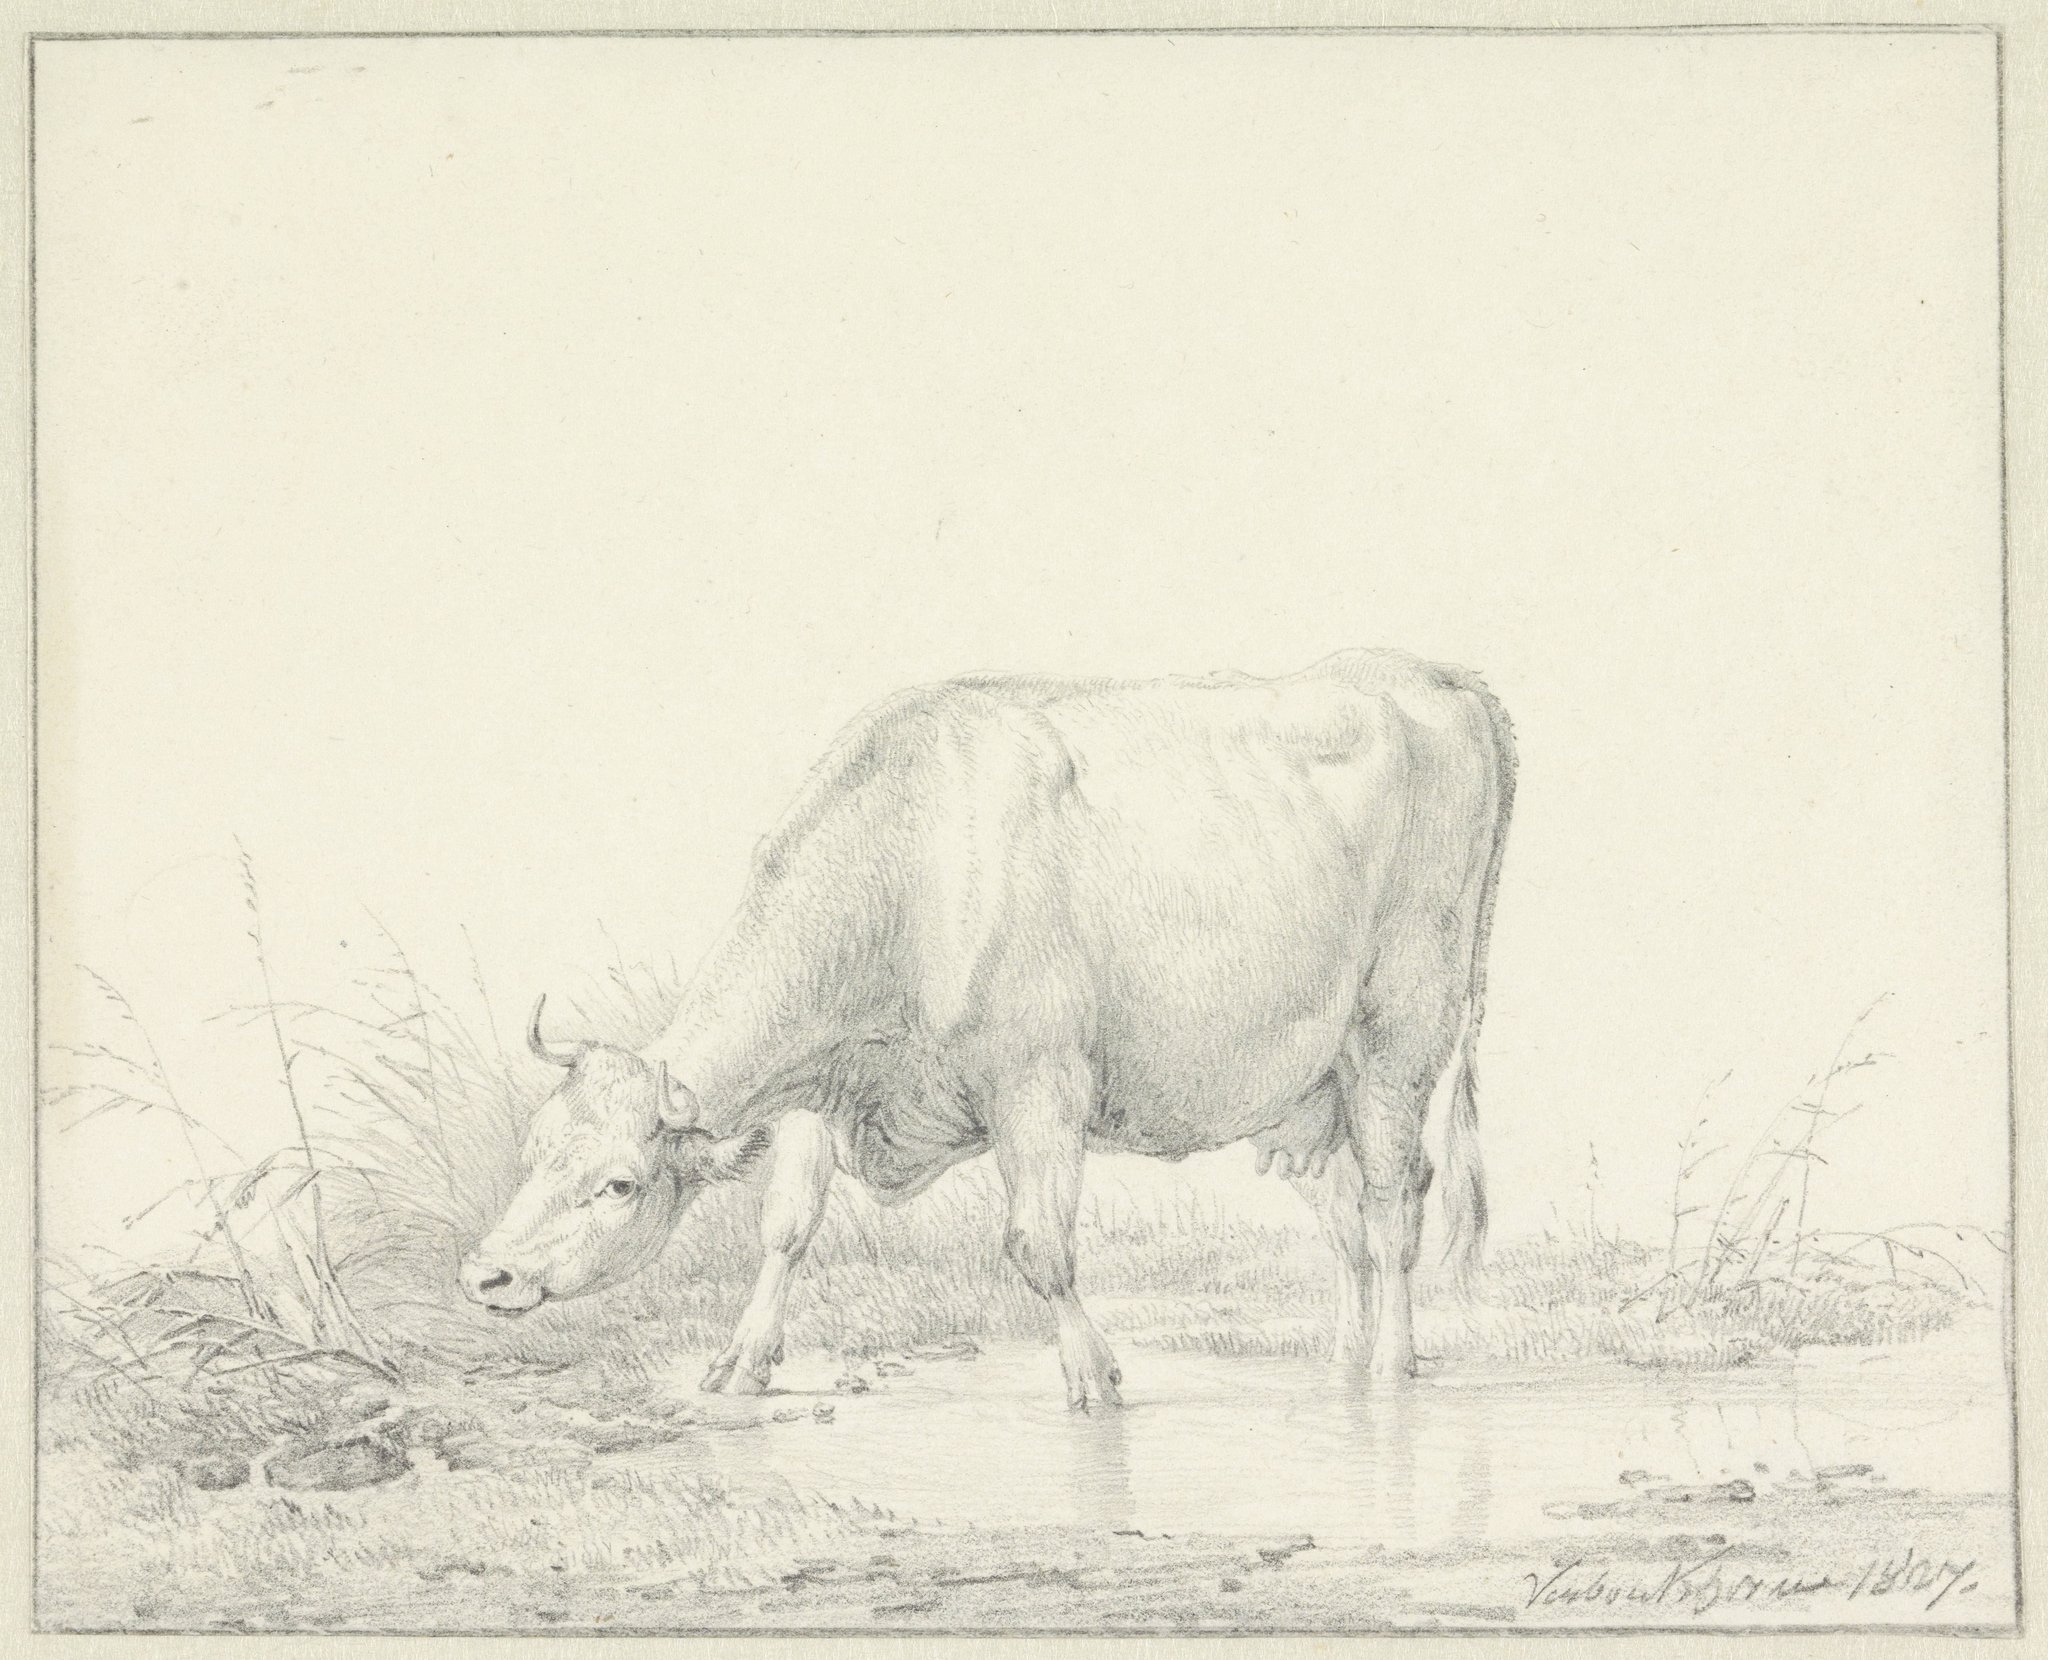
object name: drawing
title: Koe, staande in een plas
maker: eugène verboeckhoven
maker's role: draughtsman, painter, print maker, printer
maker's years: 1798-1881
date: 1827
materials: paper, pencil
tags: cow